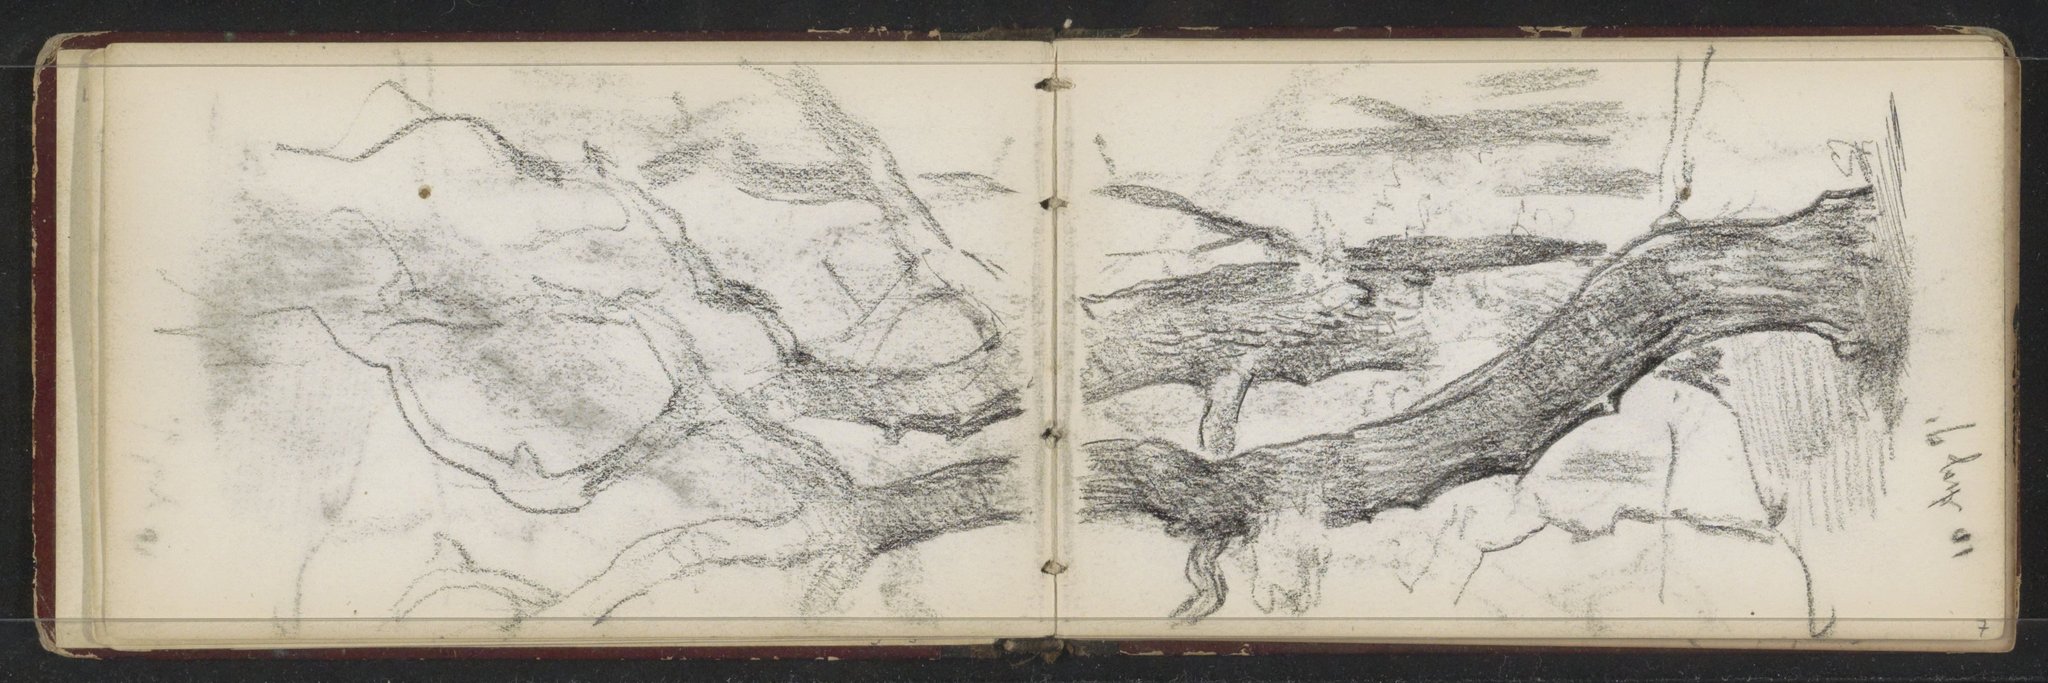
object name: sketchbook leaf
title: Bomen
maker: willem cornelis rip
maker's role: draughtsman, painter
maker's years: 1856-1922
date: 1808-1891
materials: chalk, paper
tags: trees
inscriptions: date: ‘10 Aug 91’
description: Blad 6 verso en 7 recto uit een schetsboek met 28 bladen.